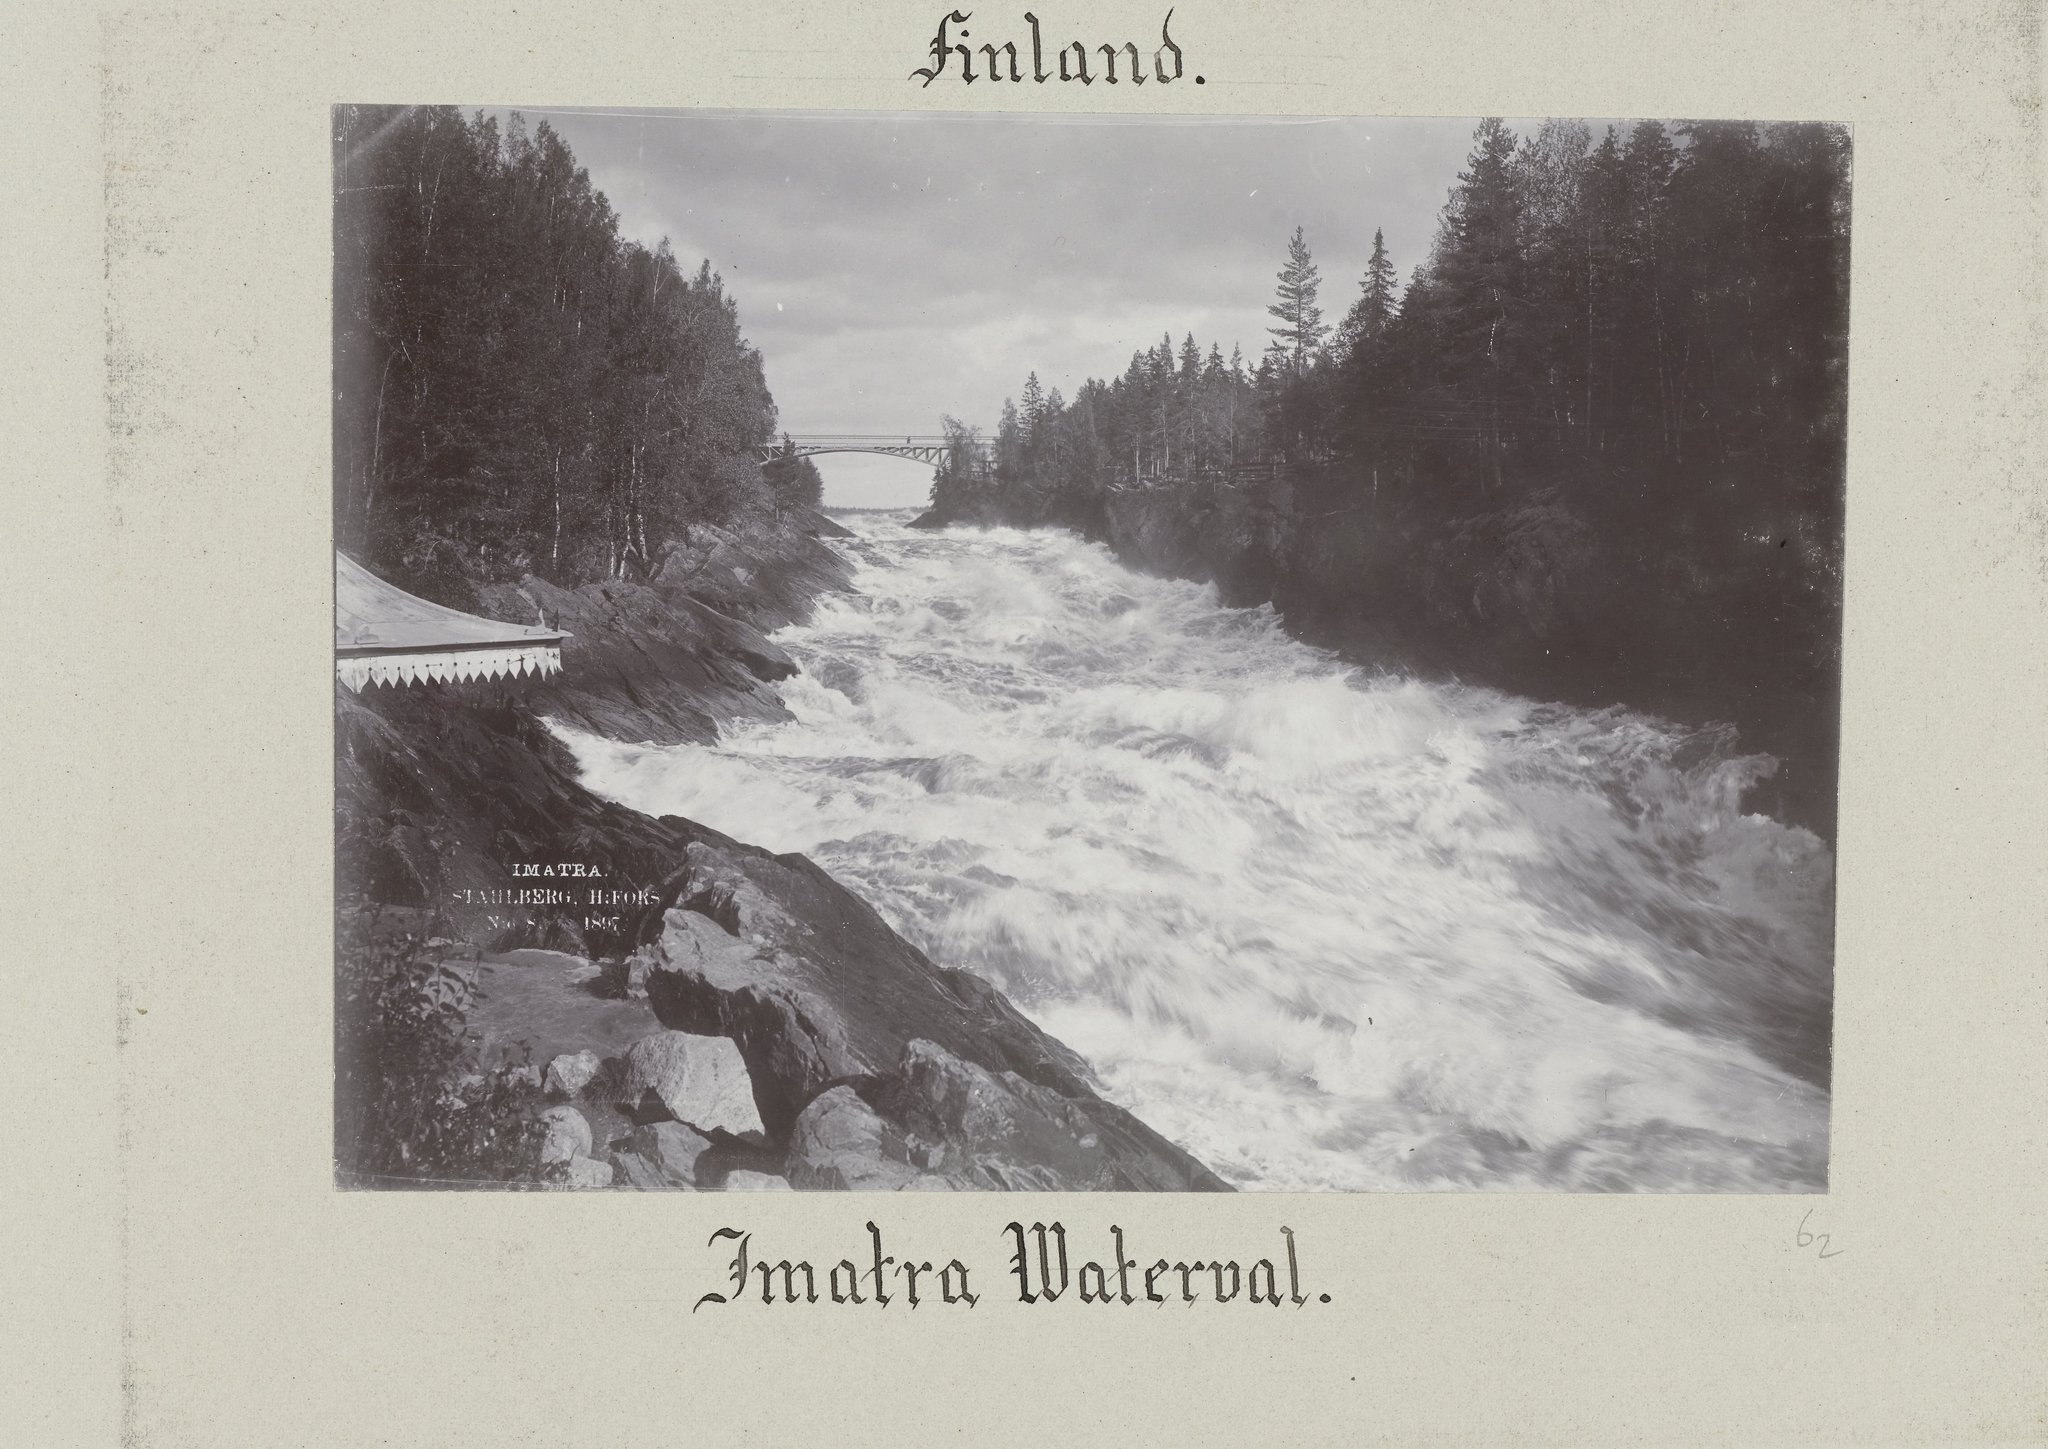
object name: photograph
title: Imatra Stahlberg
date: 1898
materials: paper, photographic support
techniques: albumen print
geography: helsinki